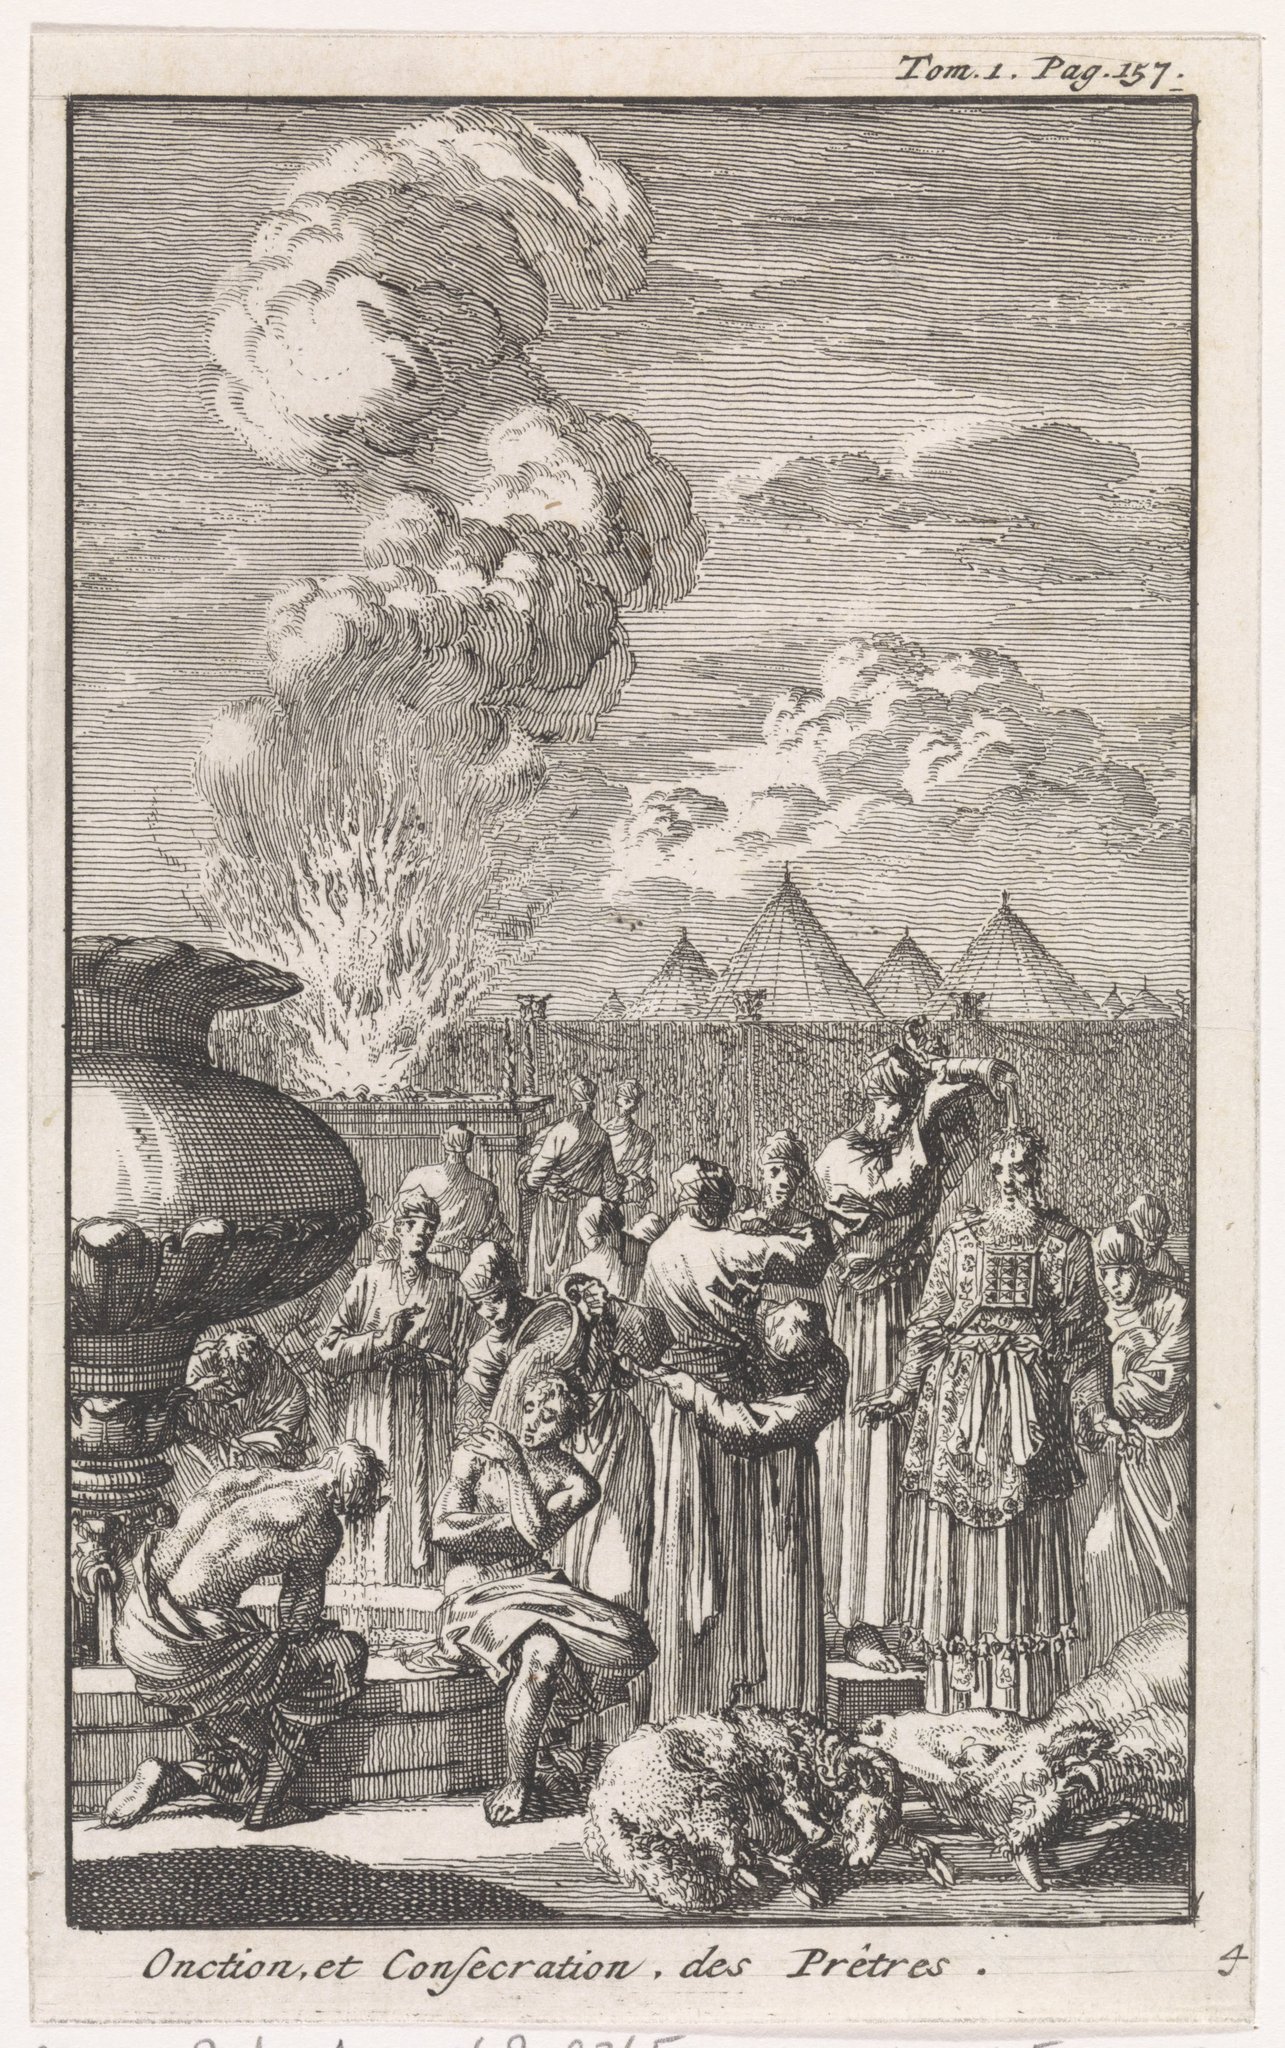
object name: book illustration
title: Onction, et Consecration, des Prêtres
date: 1705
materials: paper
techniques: etching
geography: amsterdam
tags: ritual practices ~ purification, blessing (non-christian religions)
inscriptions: collector's mark: Lugt 2228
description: Illustratie uit: Cunaeus, Petrus. La republique des Hebreux, 3 delen. Amsterdam: Pieter Mortier, 1705, dl. I, p. 157.